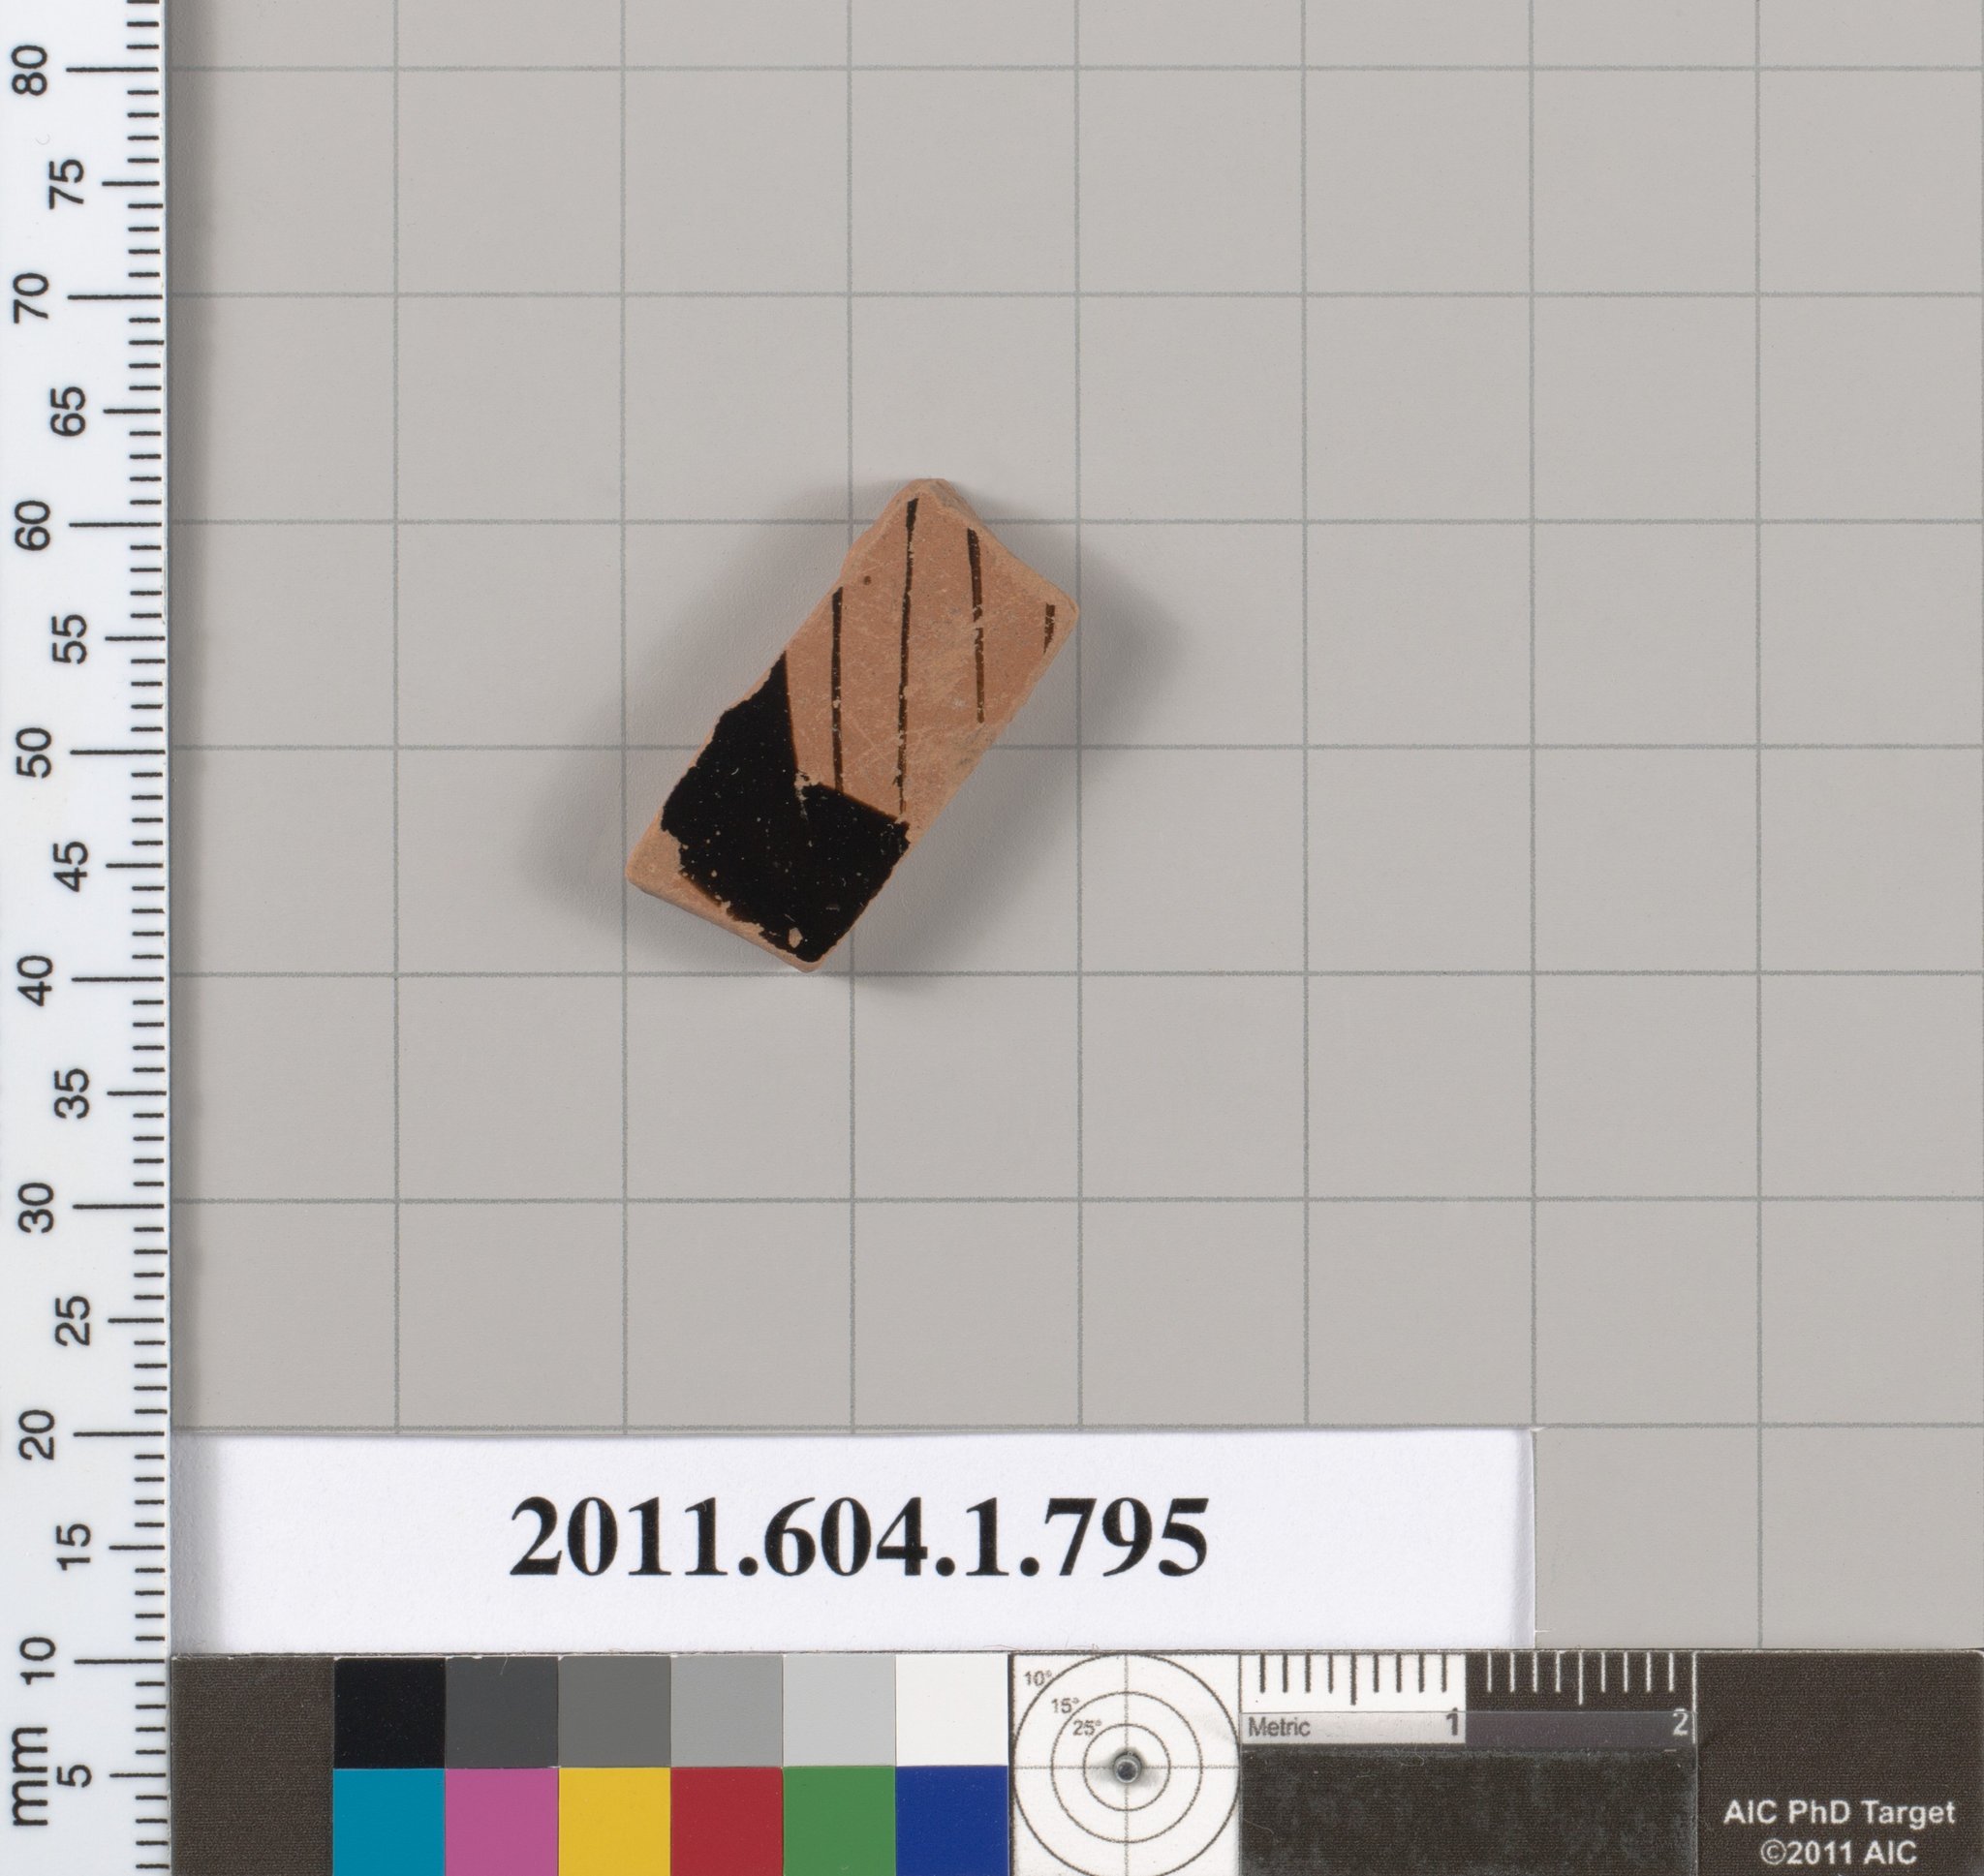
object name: kylix fragment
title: Terracotta fragment of a kylix (drinking cup)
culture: greek, attic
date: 475-451 BCE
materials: terracotta